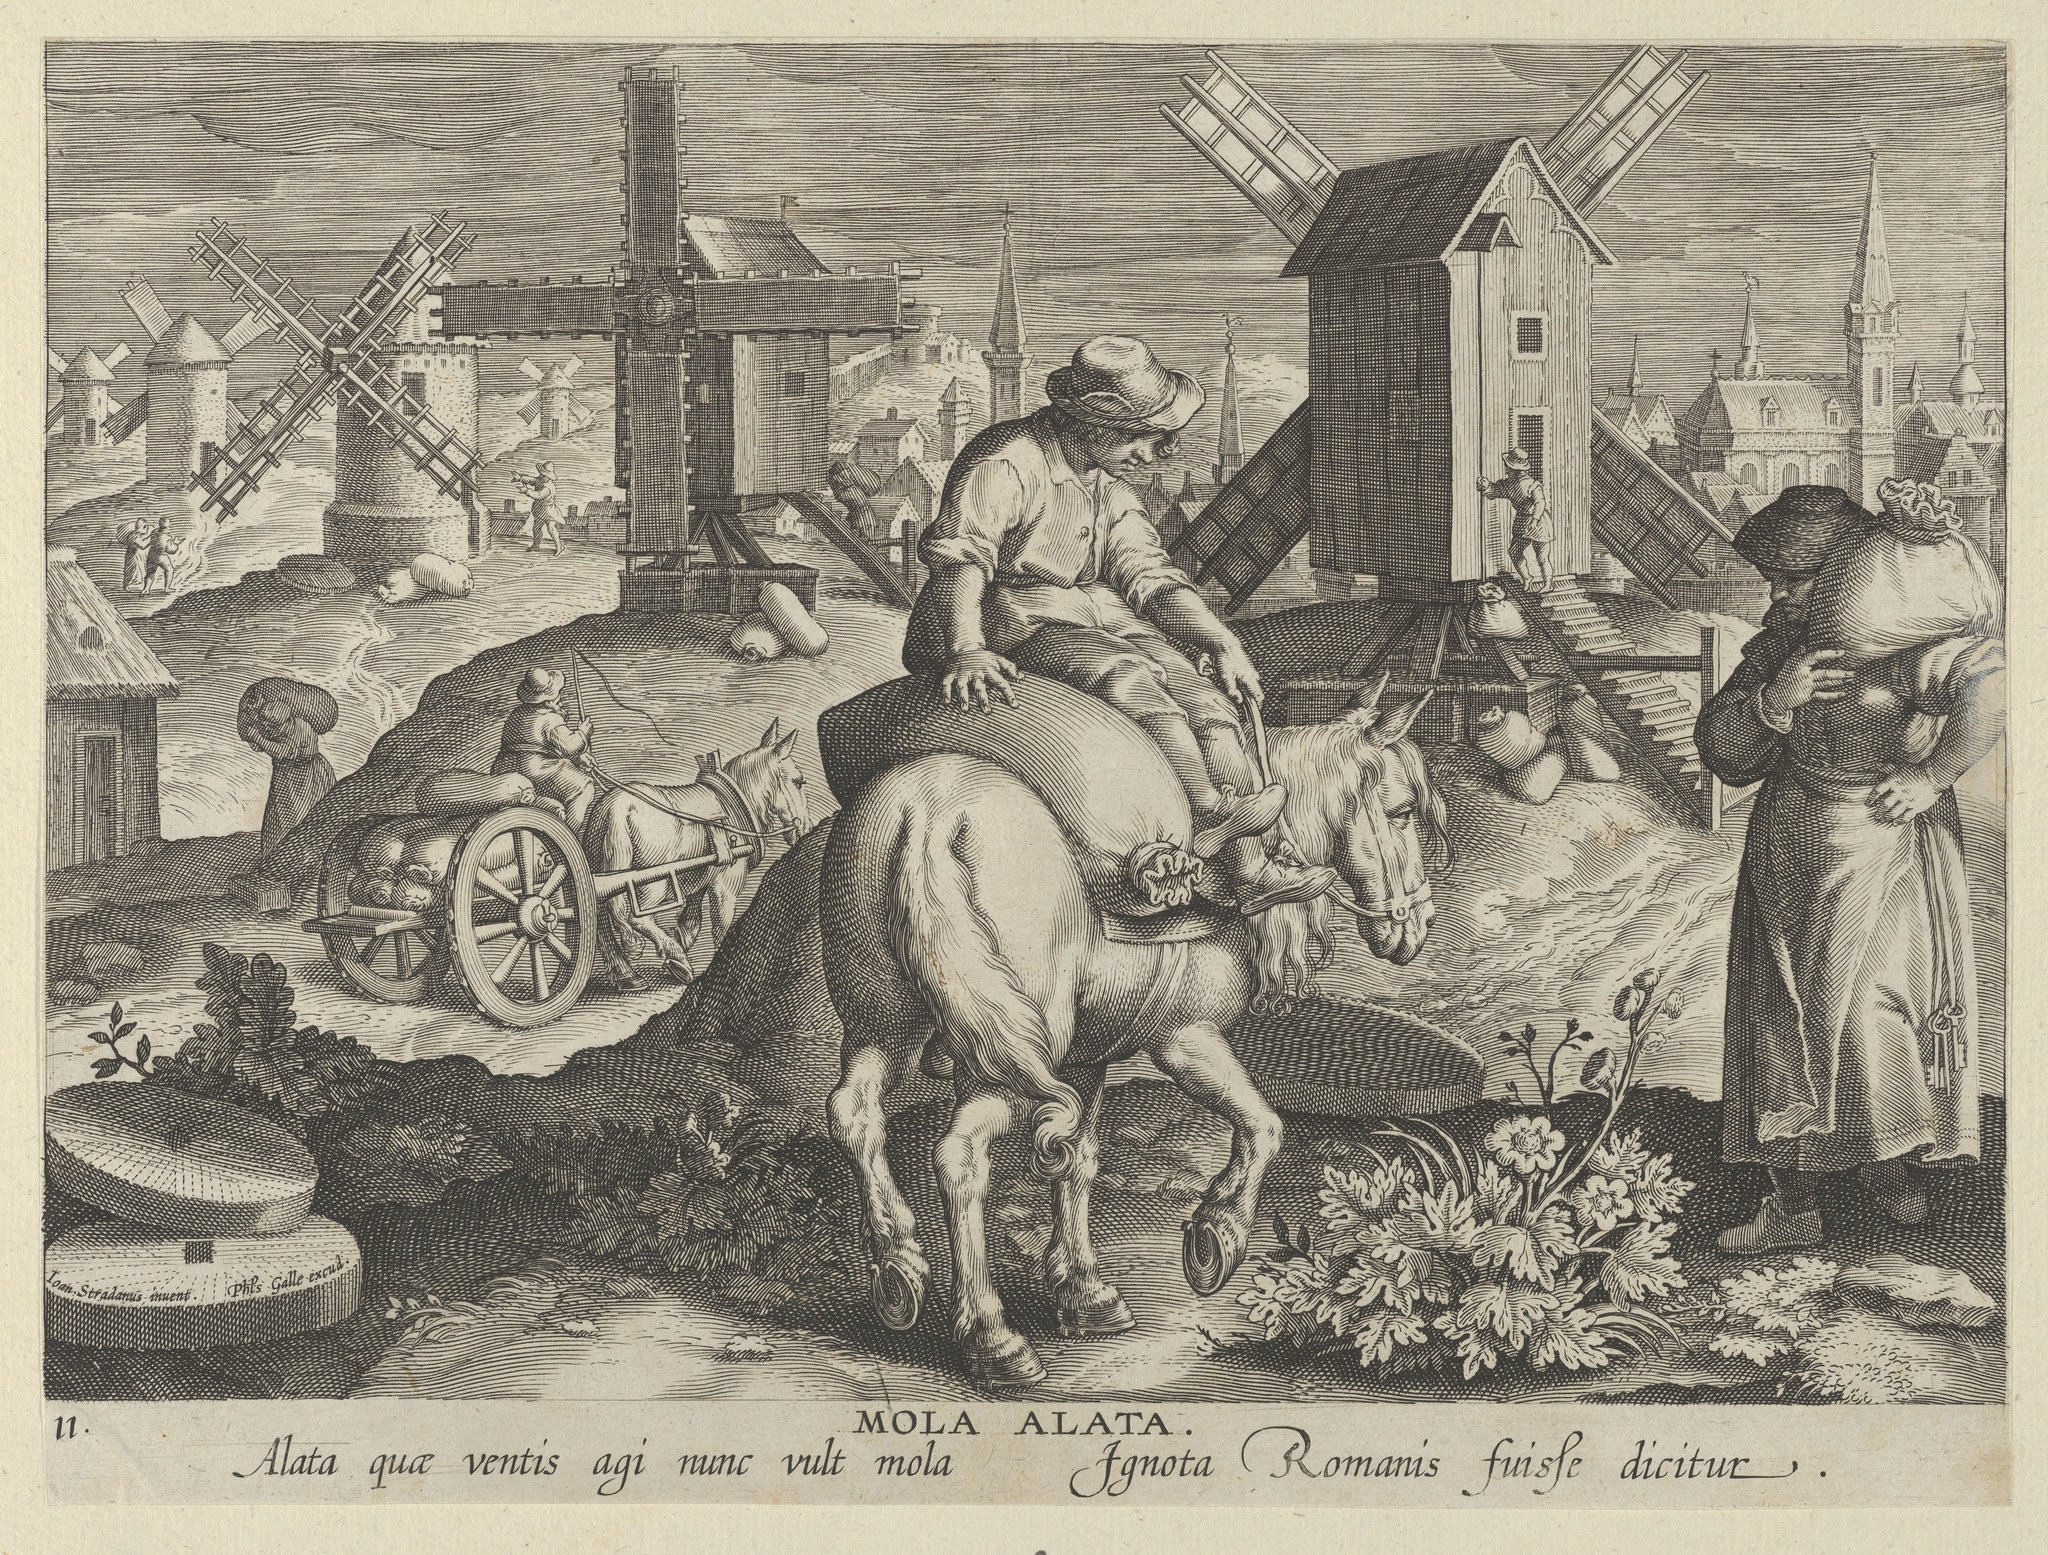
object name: print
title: New Inventions of Modern Times [Nova Reperta], The Invention of the Wind Mill, plate 11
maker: jan collaert i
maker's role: artist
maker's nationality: netherlandish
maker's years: 1530-1581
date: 1600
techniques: engraving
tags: windmills,men,women,horses,carriages